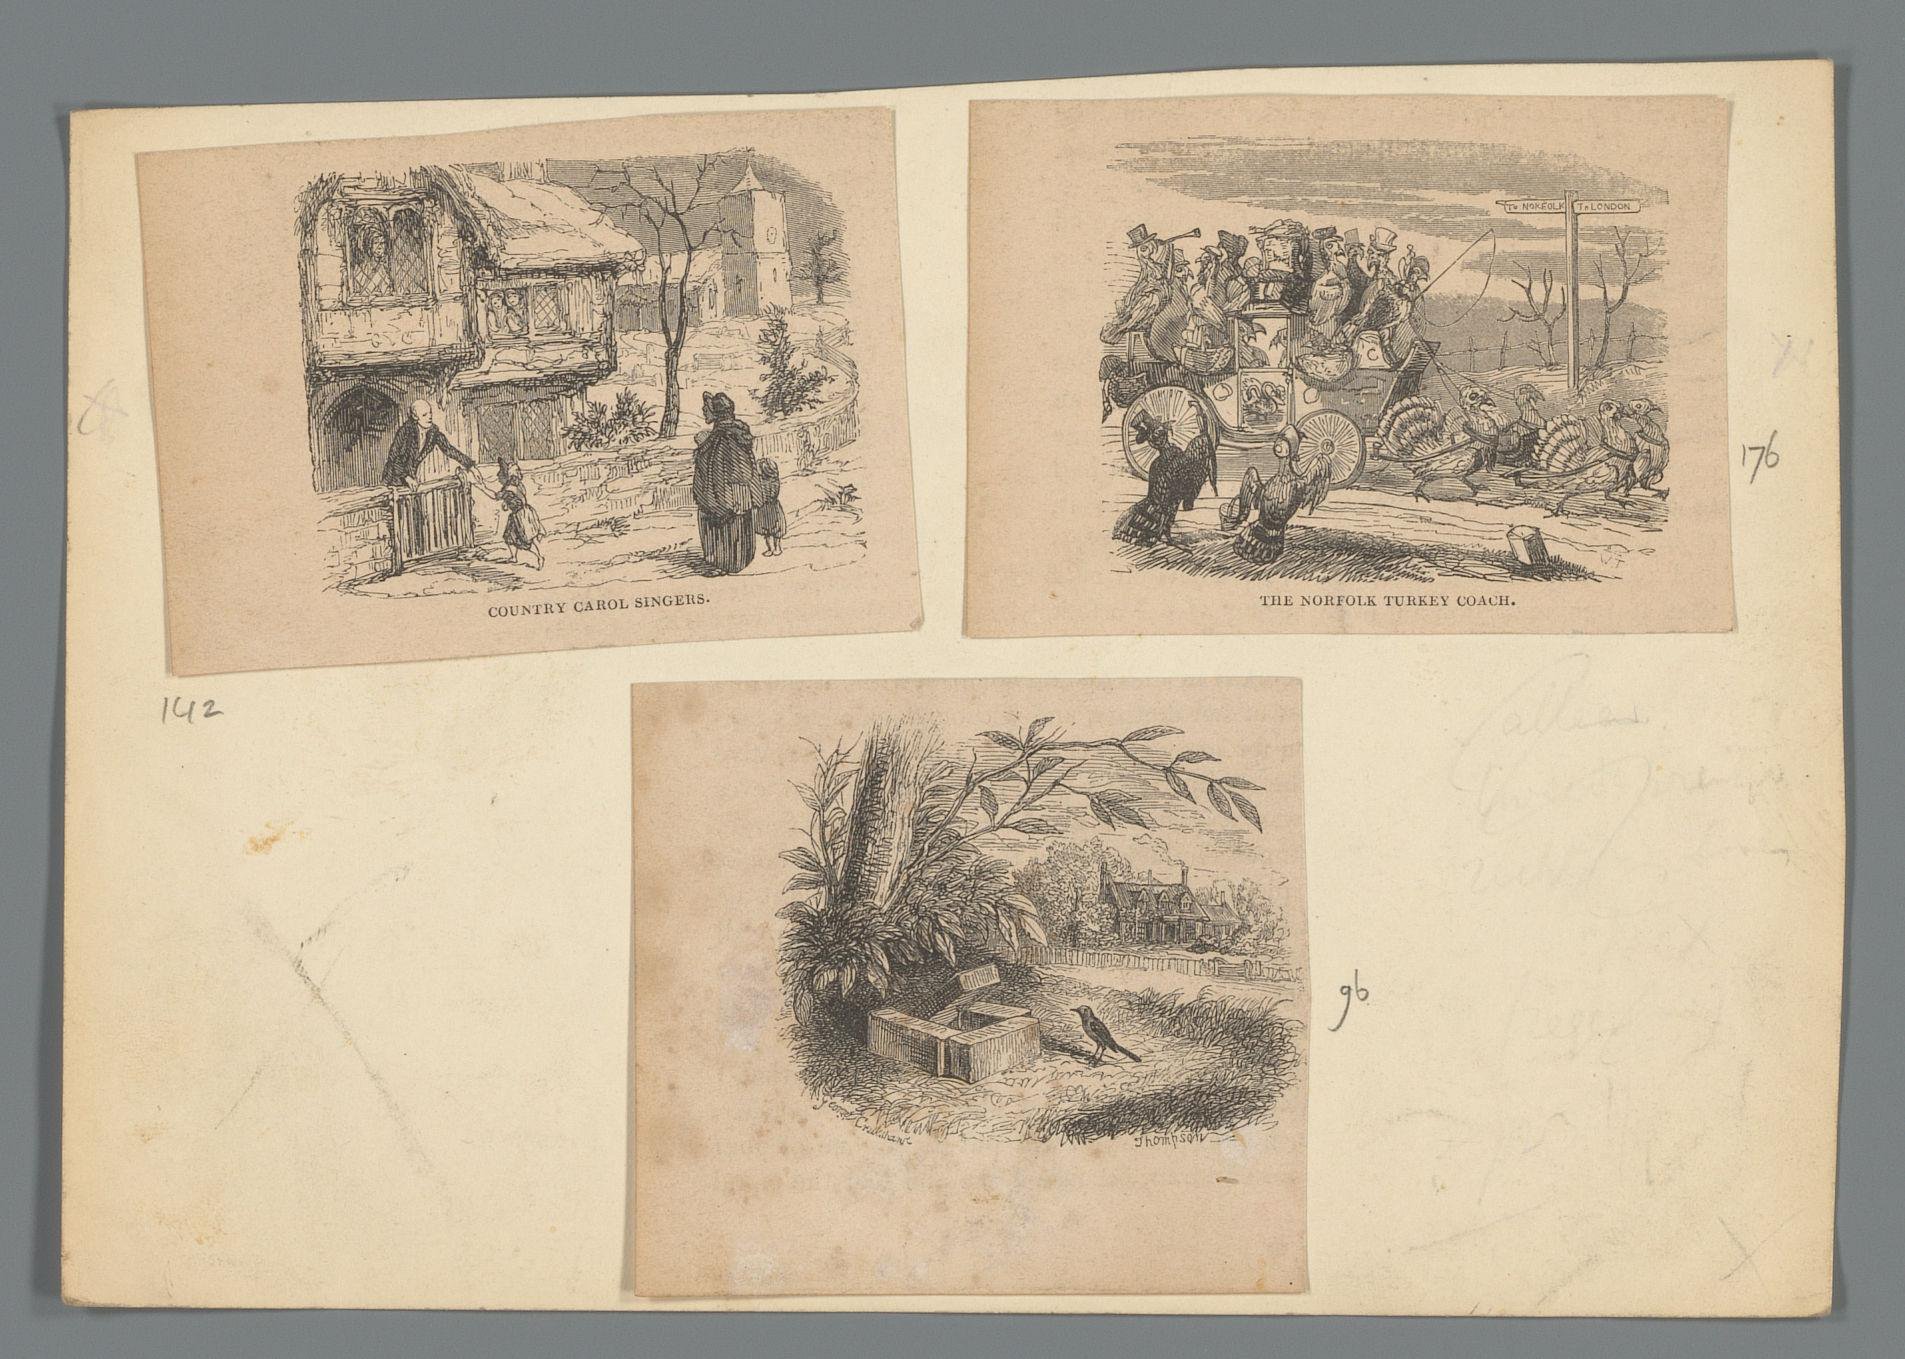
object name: book illustration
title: Drie illustraties uit: Peter Parley’s Tales About Christmas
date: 1836-1838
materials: paper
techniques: engraving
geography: england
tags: christmas (non-liturgical celebration), animals acting as human beings, four-wheeled, animal-drawn vehicle, e.g.: cab, carriage, coach, vocal music, singing - cc - out of doors, walker and runner birds: turkey, political caricatures and satires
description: Drie boekillustraties geknipt uit een uitgave van Peter Parley’s Tales About Christmas (1838), p. 96, 142 en 176. Opgeplakt op een stuk papier.